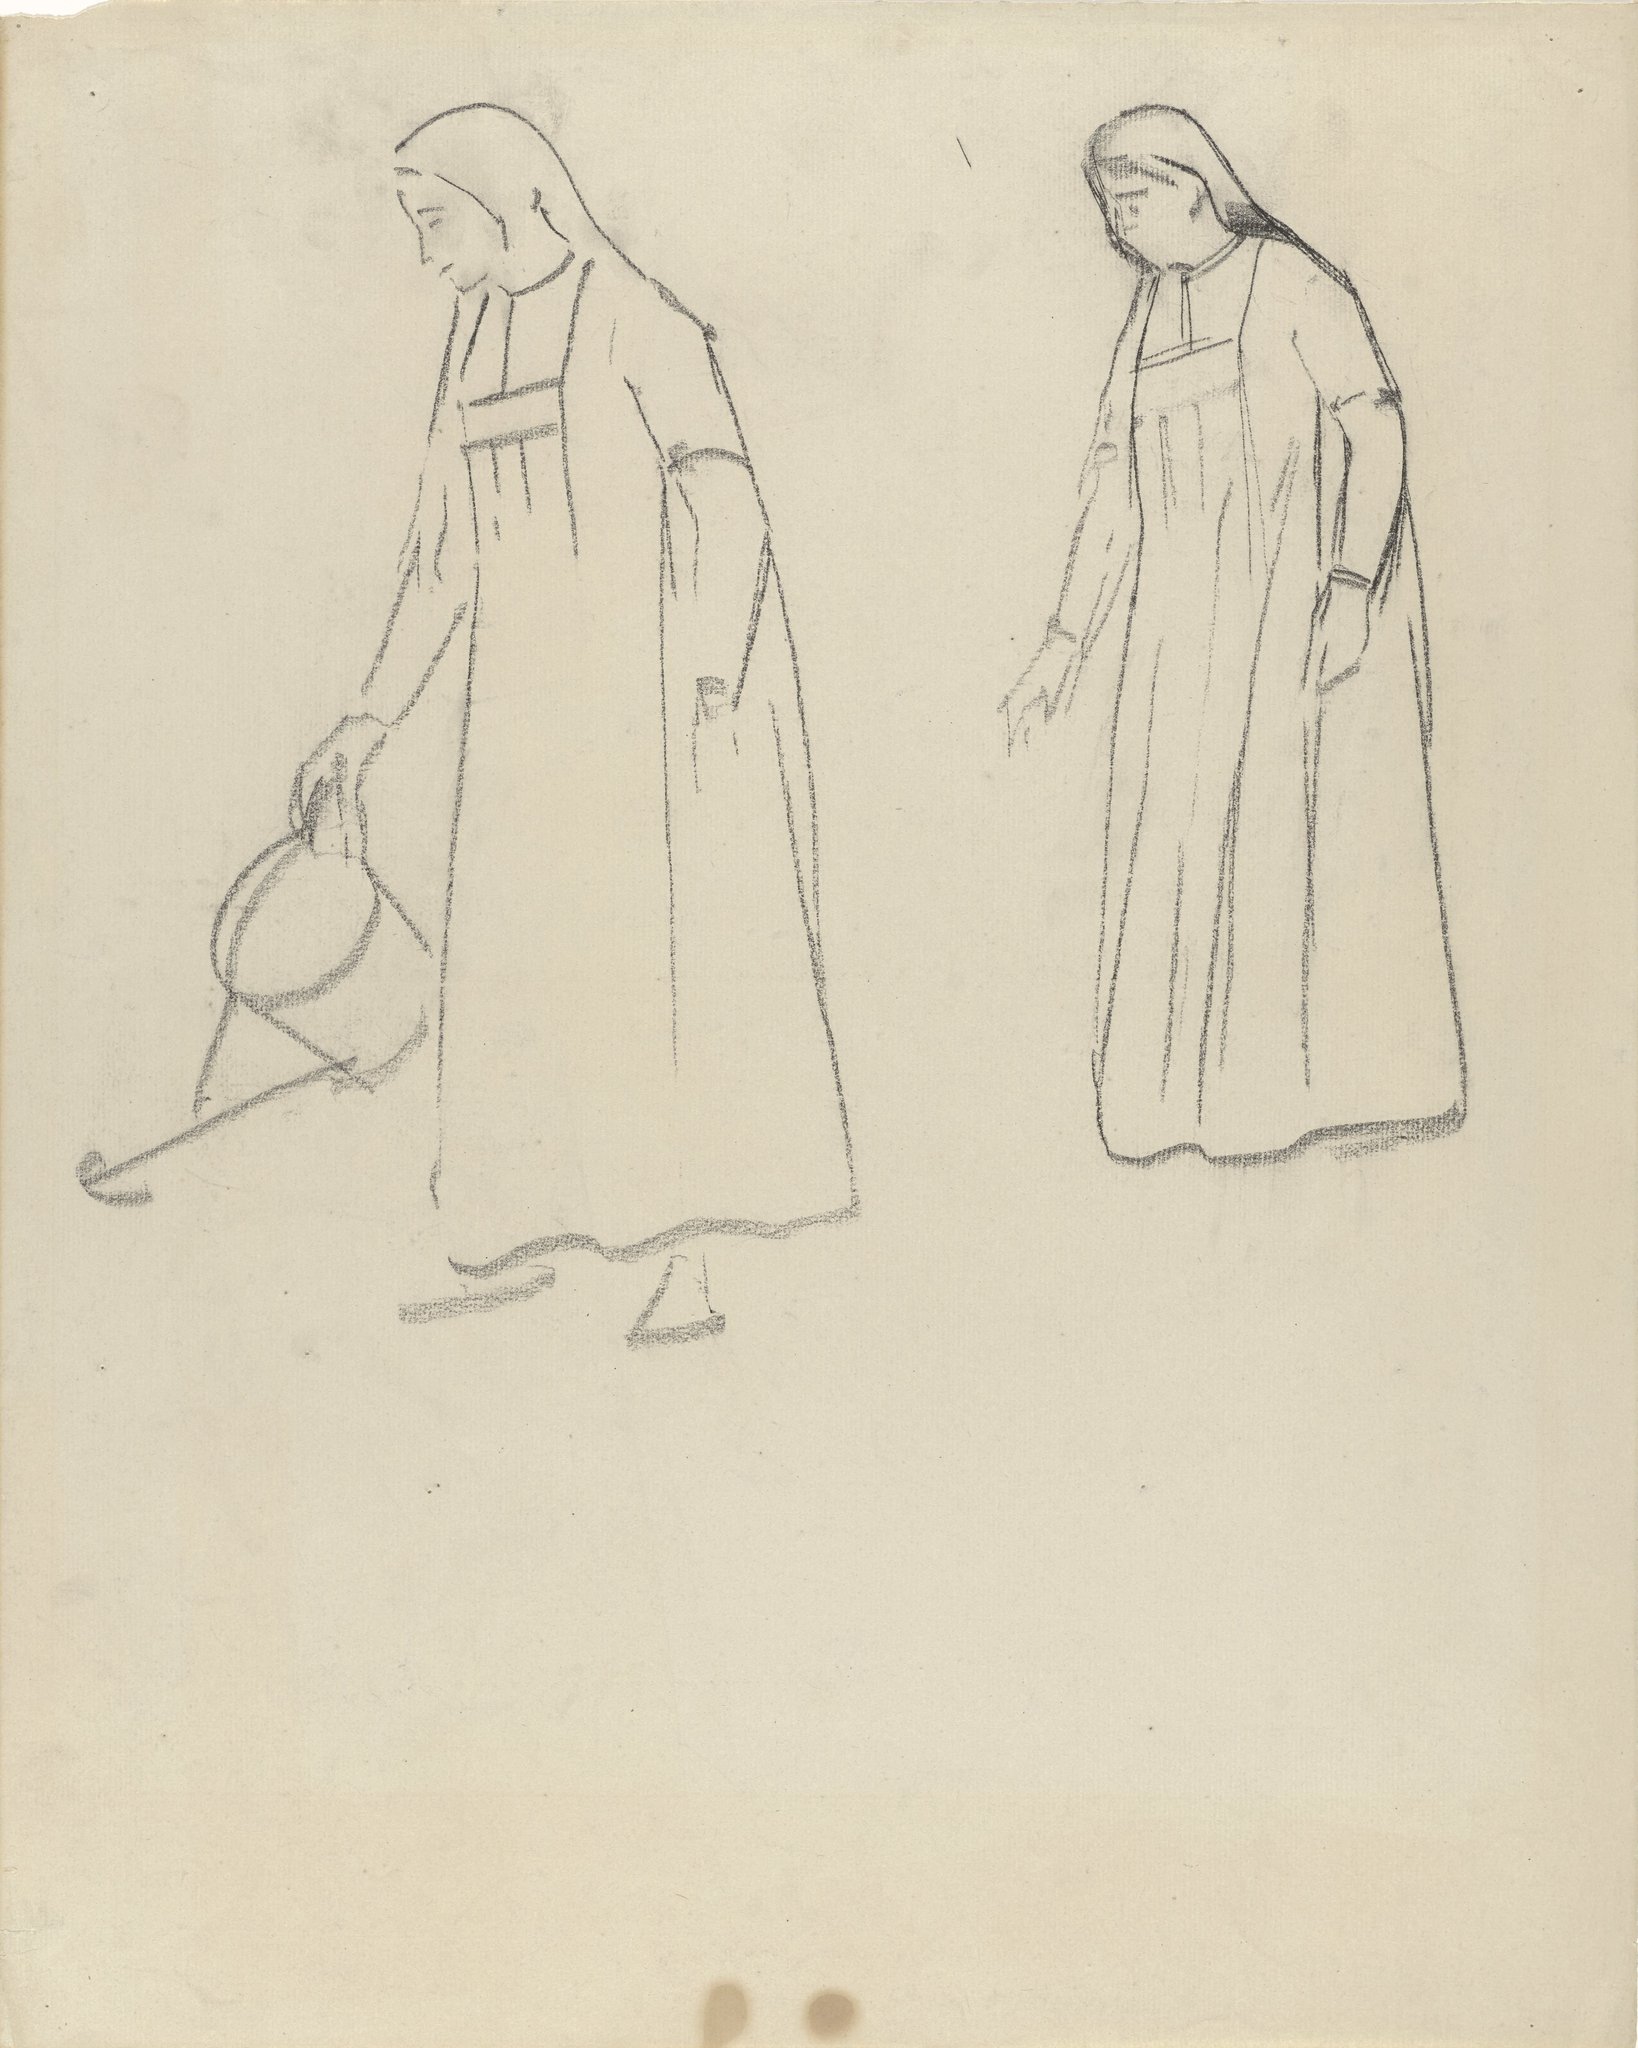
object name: design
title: Studies voor kalender van 1901: staande vrouw die planten water geeft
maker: gerrit willem dijsselhof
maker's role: designer, draughtsman, print maker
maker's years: 1866-1924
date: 1876-1924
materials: chalk, paper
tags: gardening